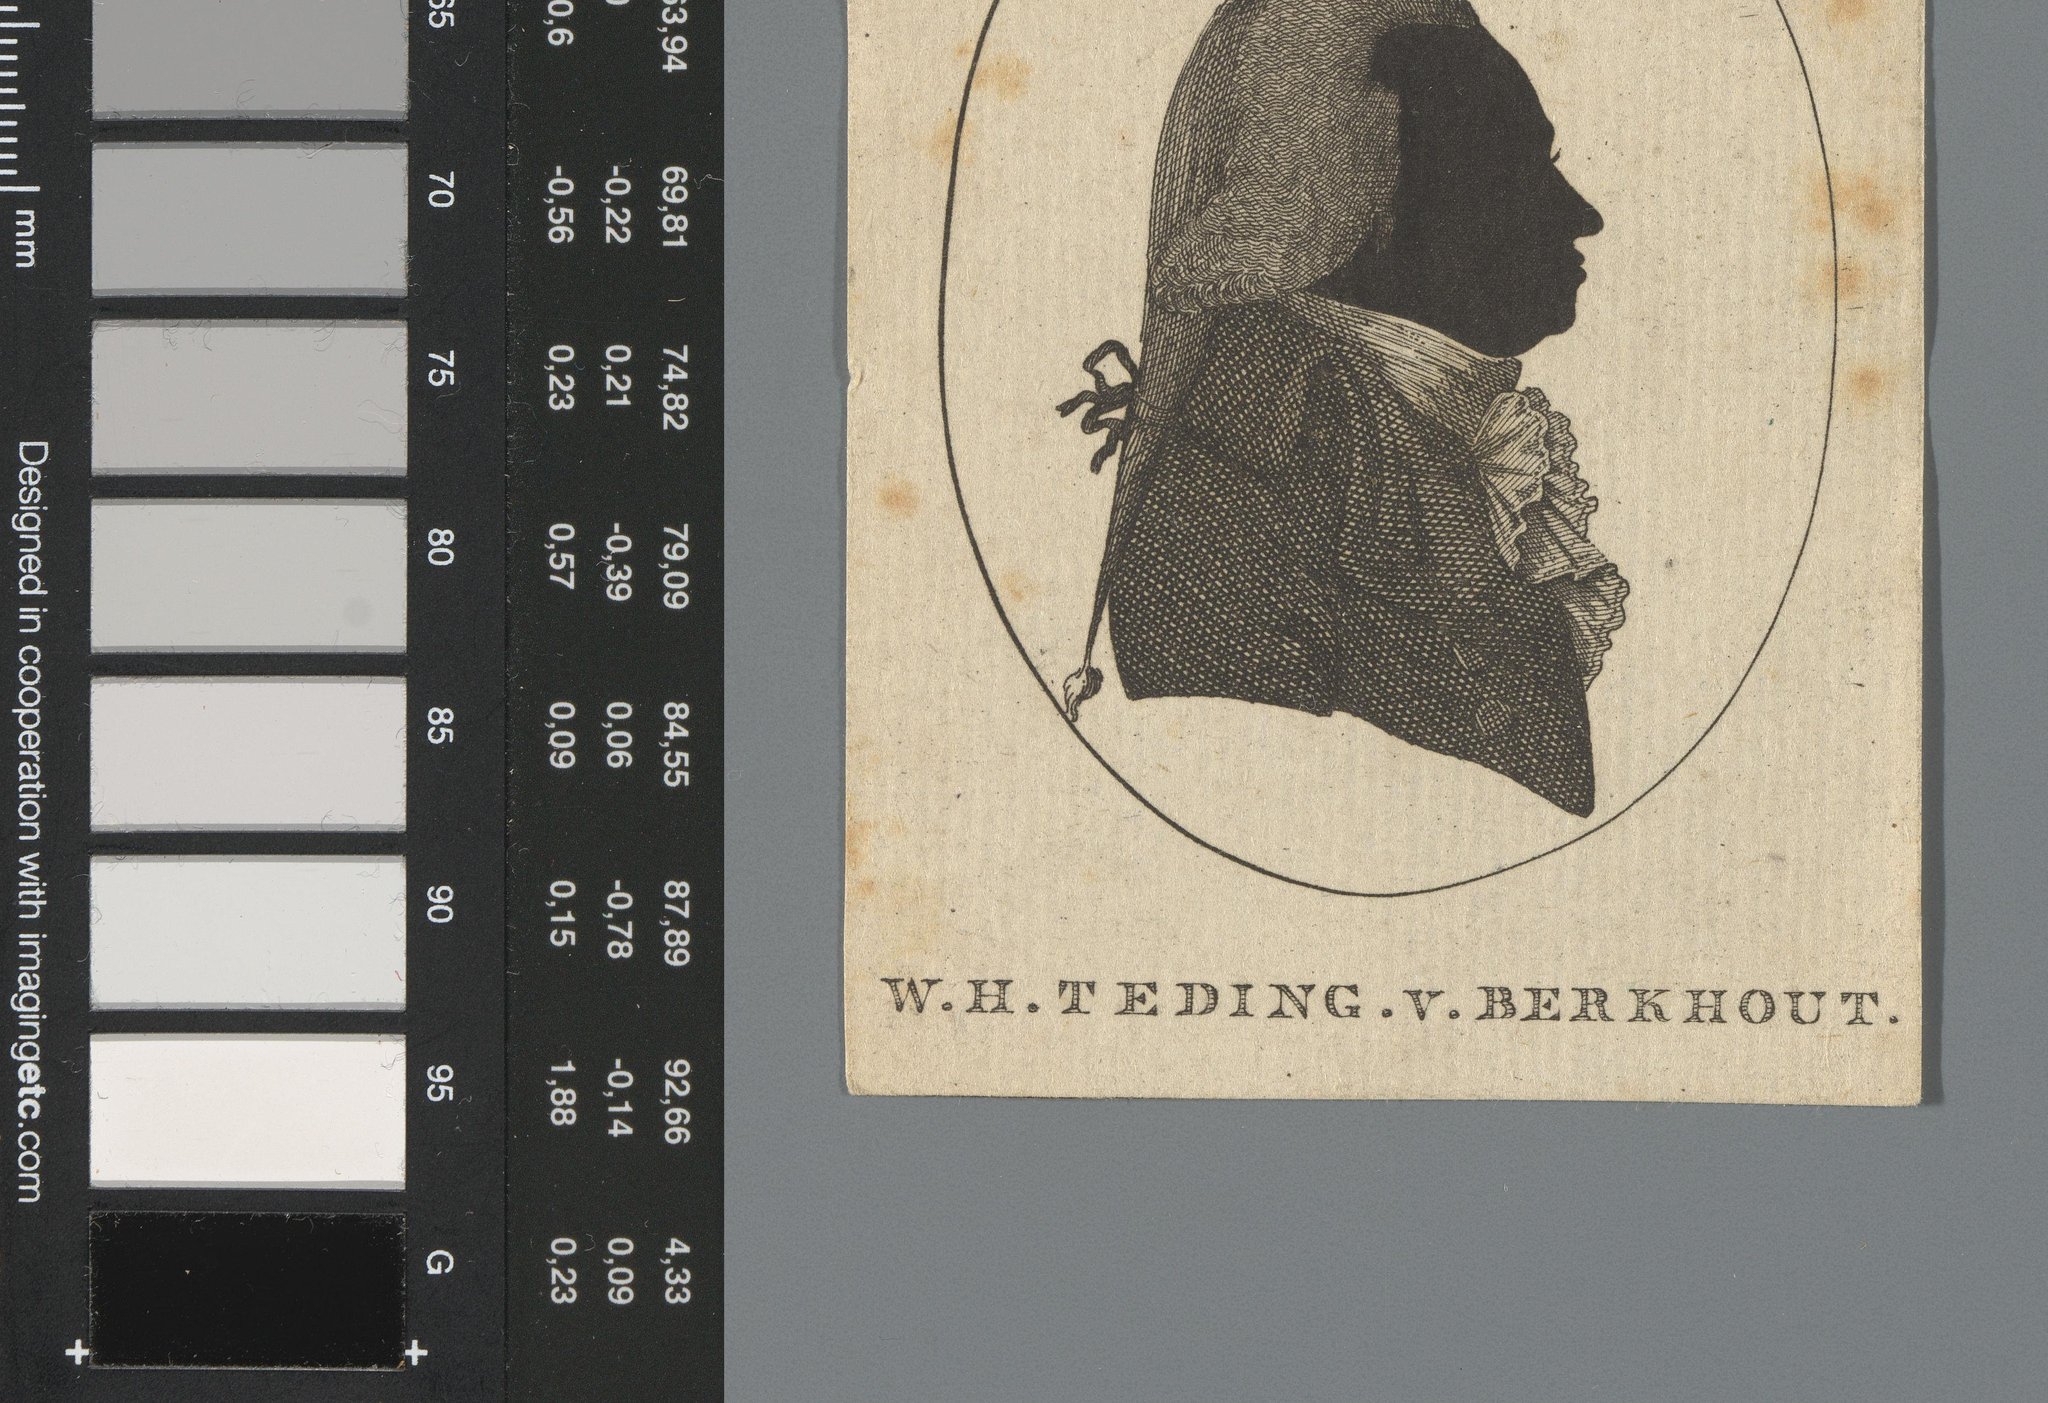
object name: print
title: Silhouet van Willem Hendrik Teding van Berkhout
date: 1796-1800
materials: paper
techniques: etching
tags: historical persons, the hague, delft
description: Portret van Willem Hendrik Teding van Berkhout, silhouet van borstbeeld in profiel naar rechts, met staartpruik en jabot.